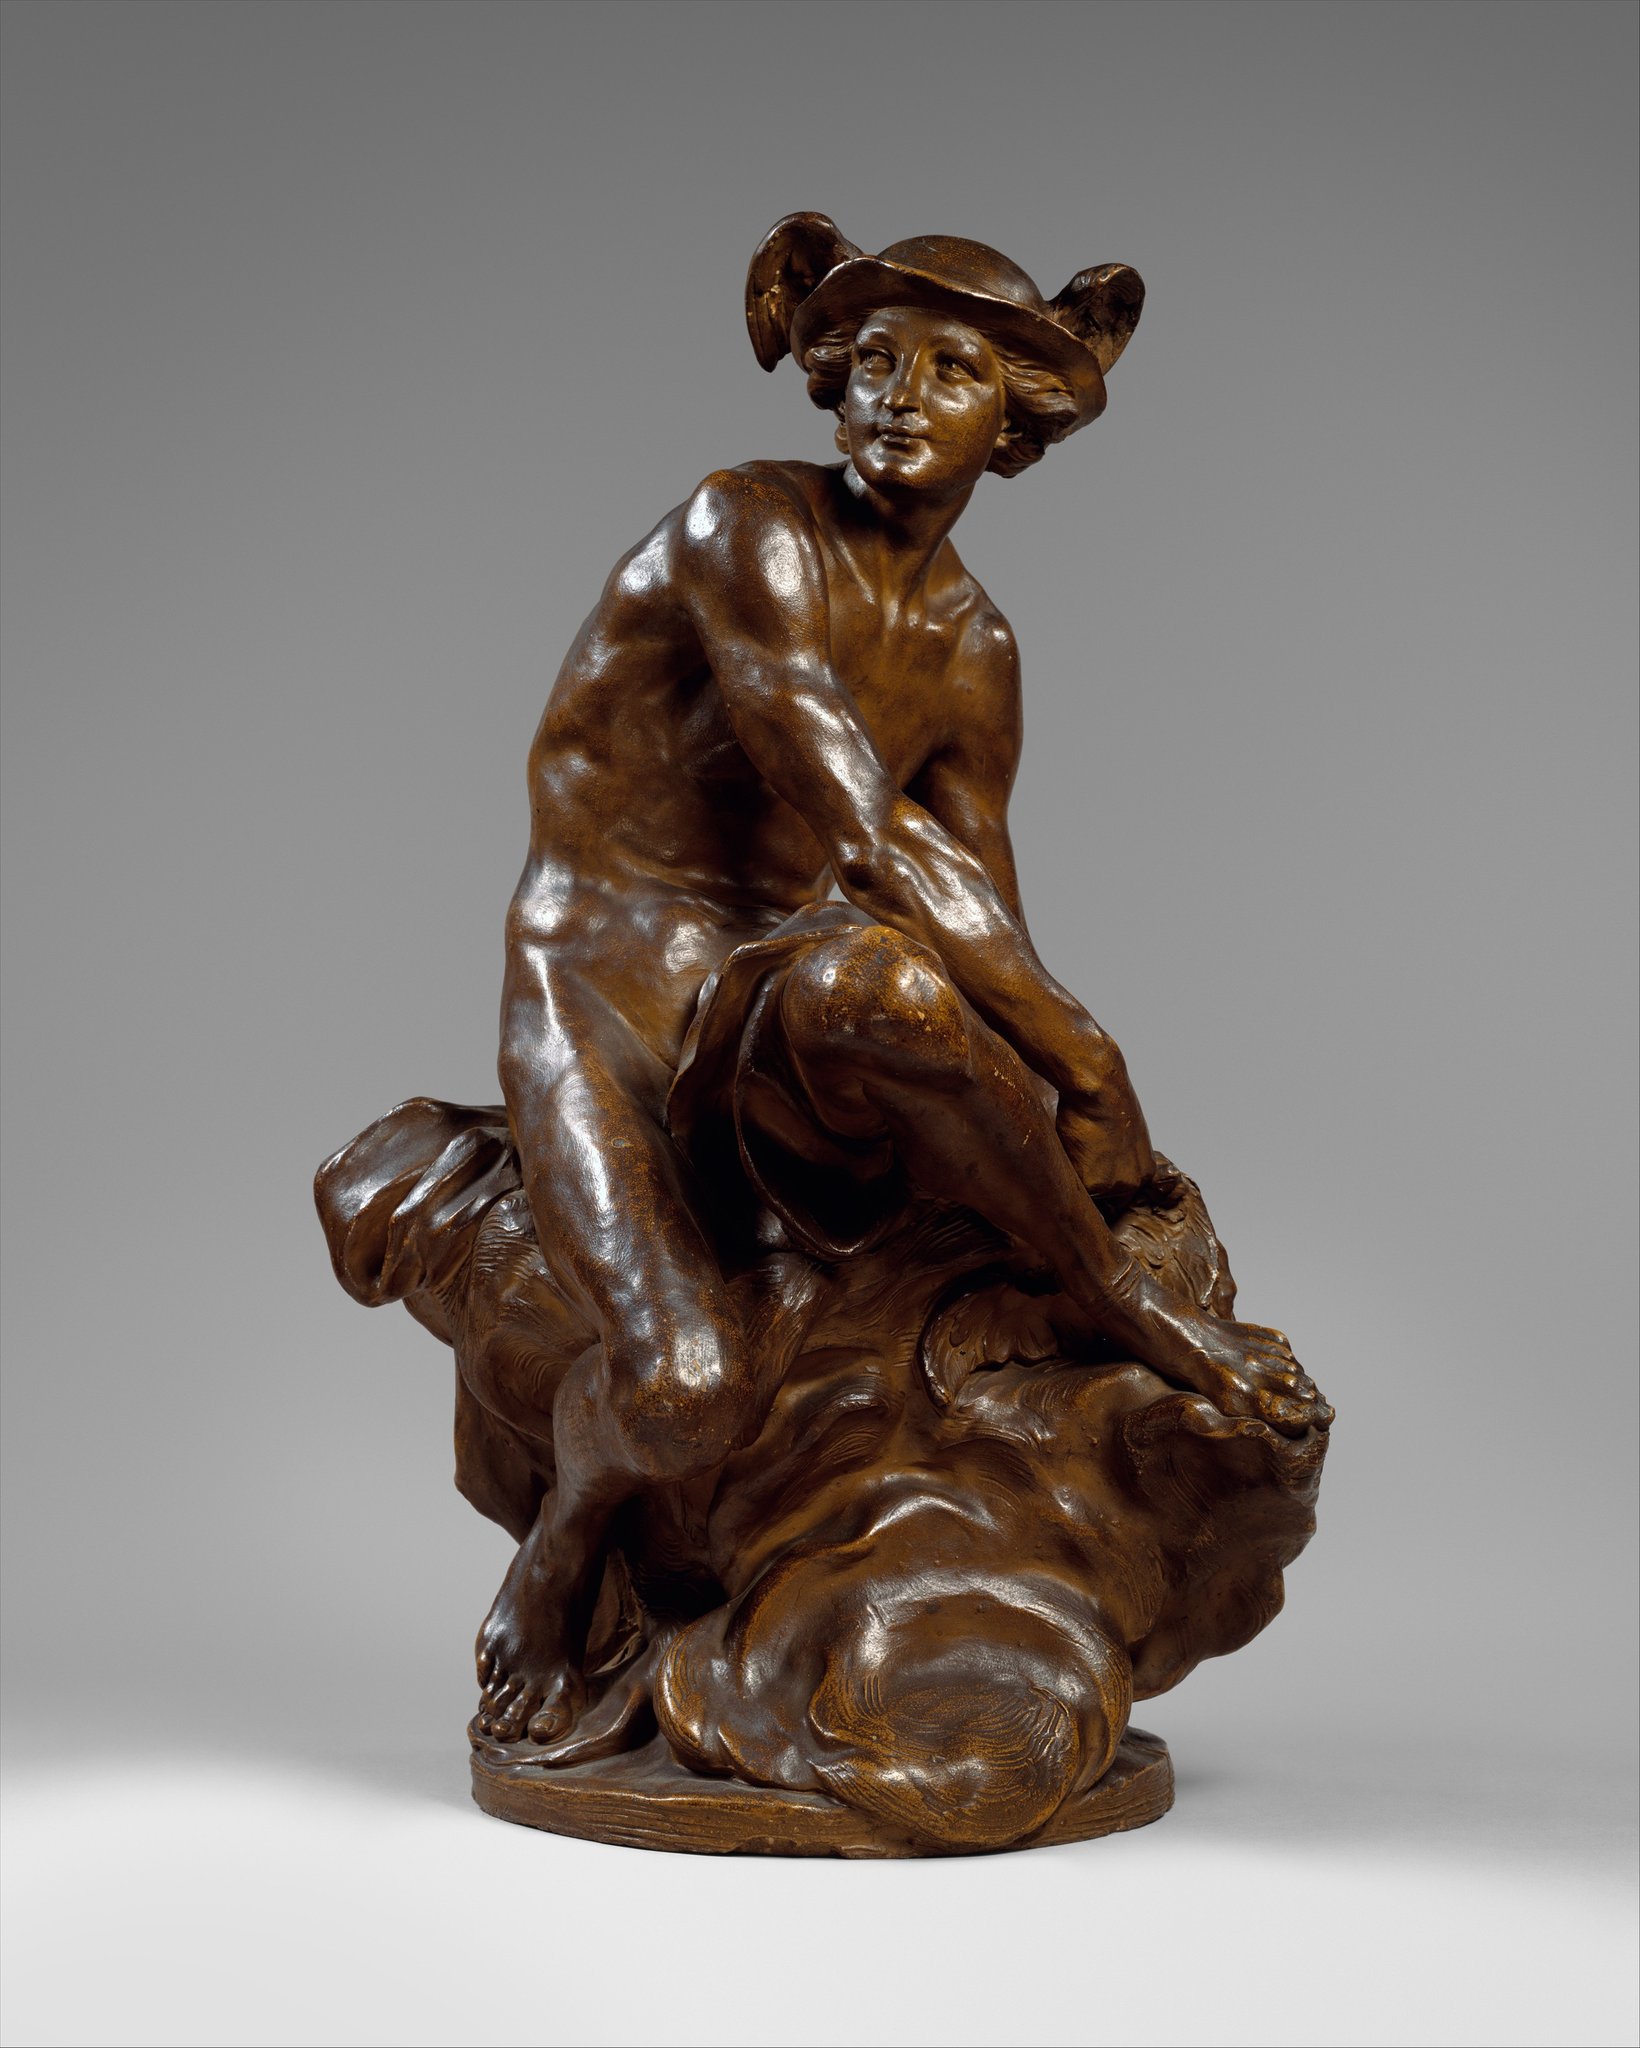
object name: statuette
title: Mercury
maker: jean-baptiste pigalle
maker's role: artist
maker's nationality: french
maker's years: 1714-1785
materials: terracotta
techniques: casting, painting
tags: mercury